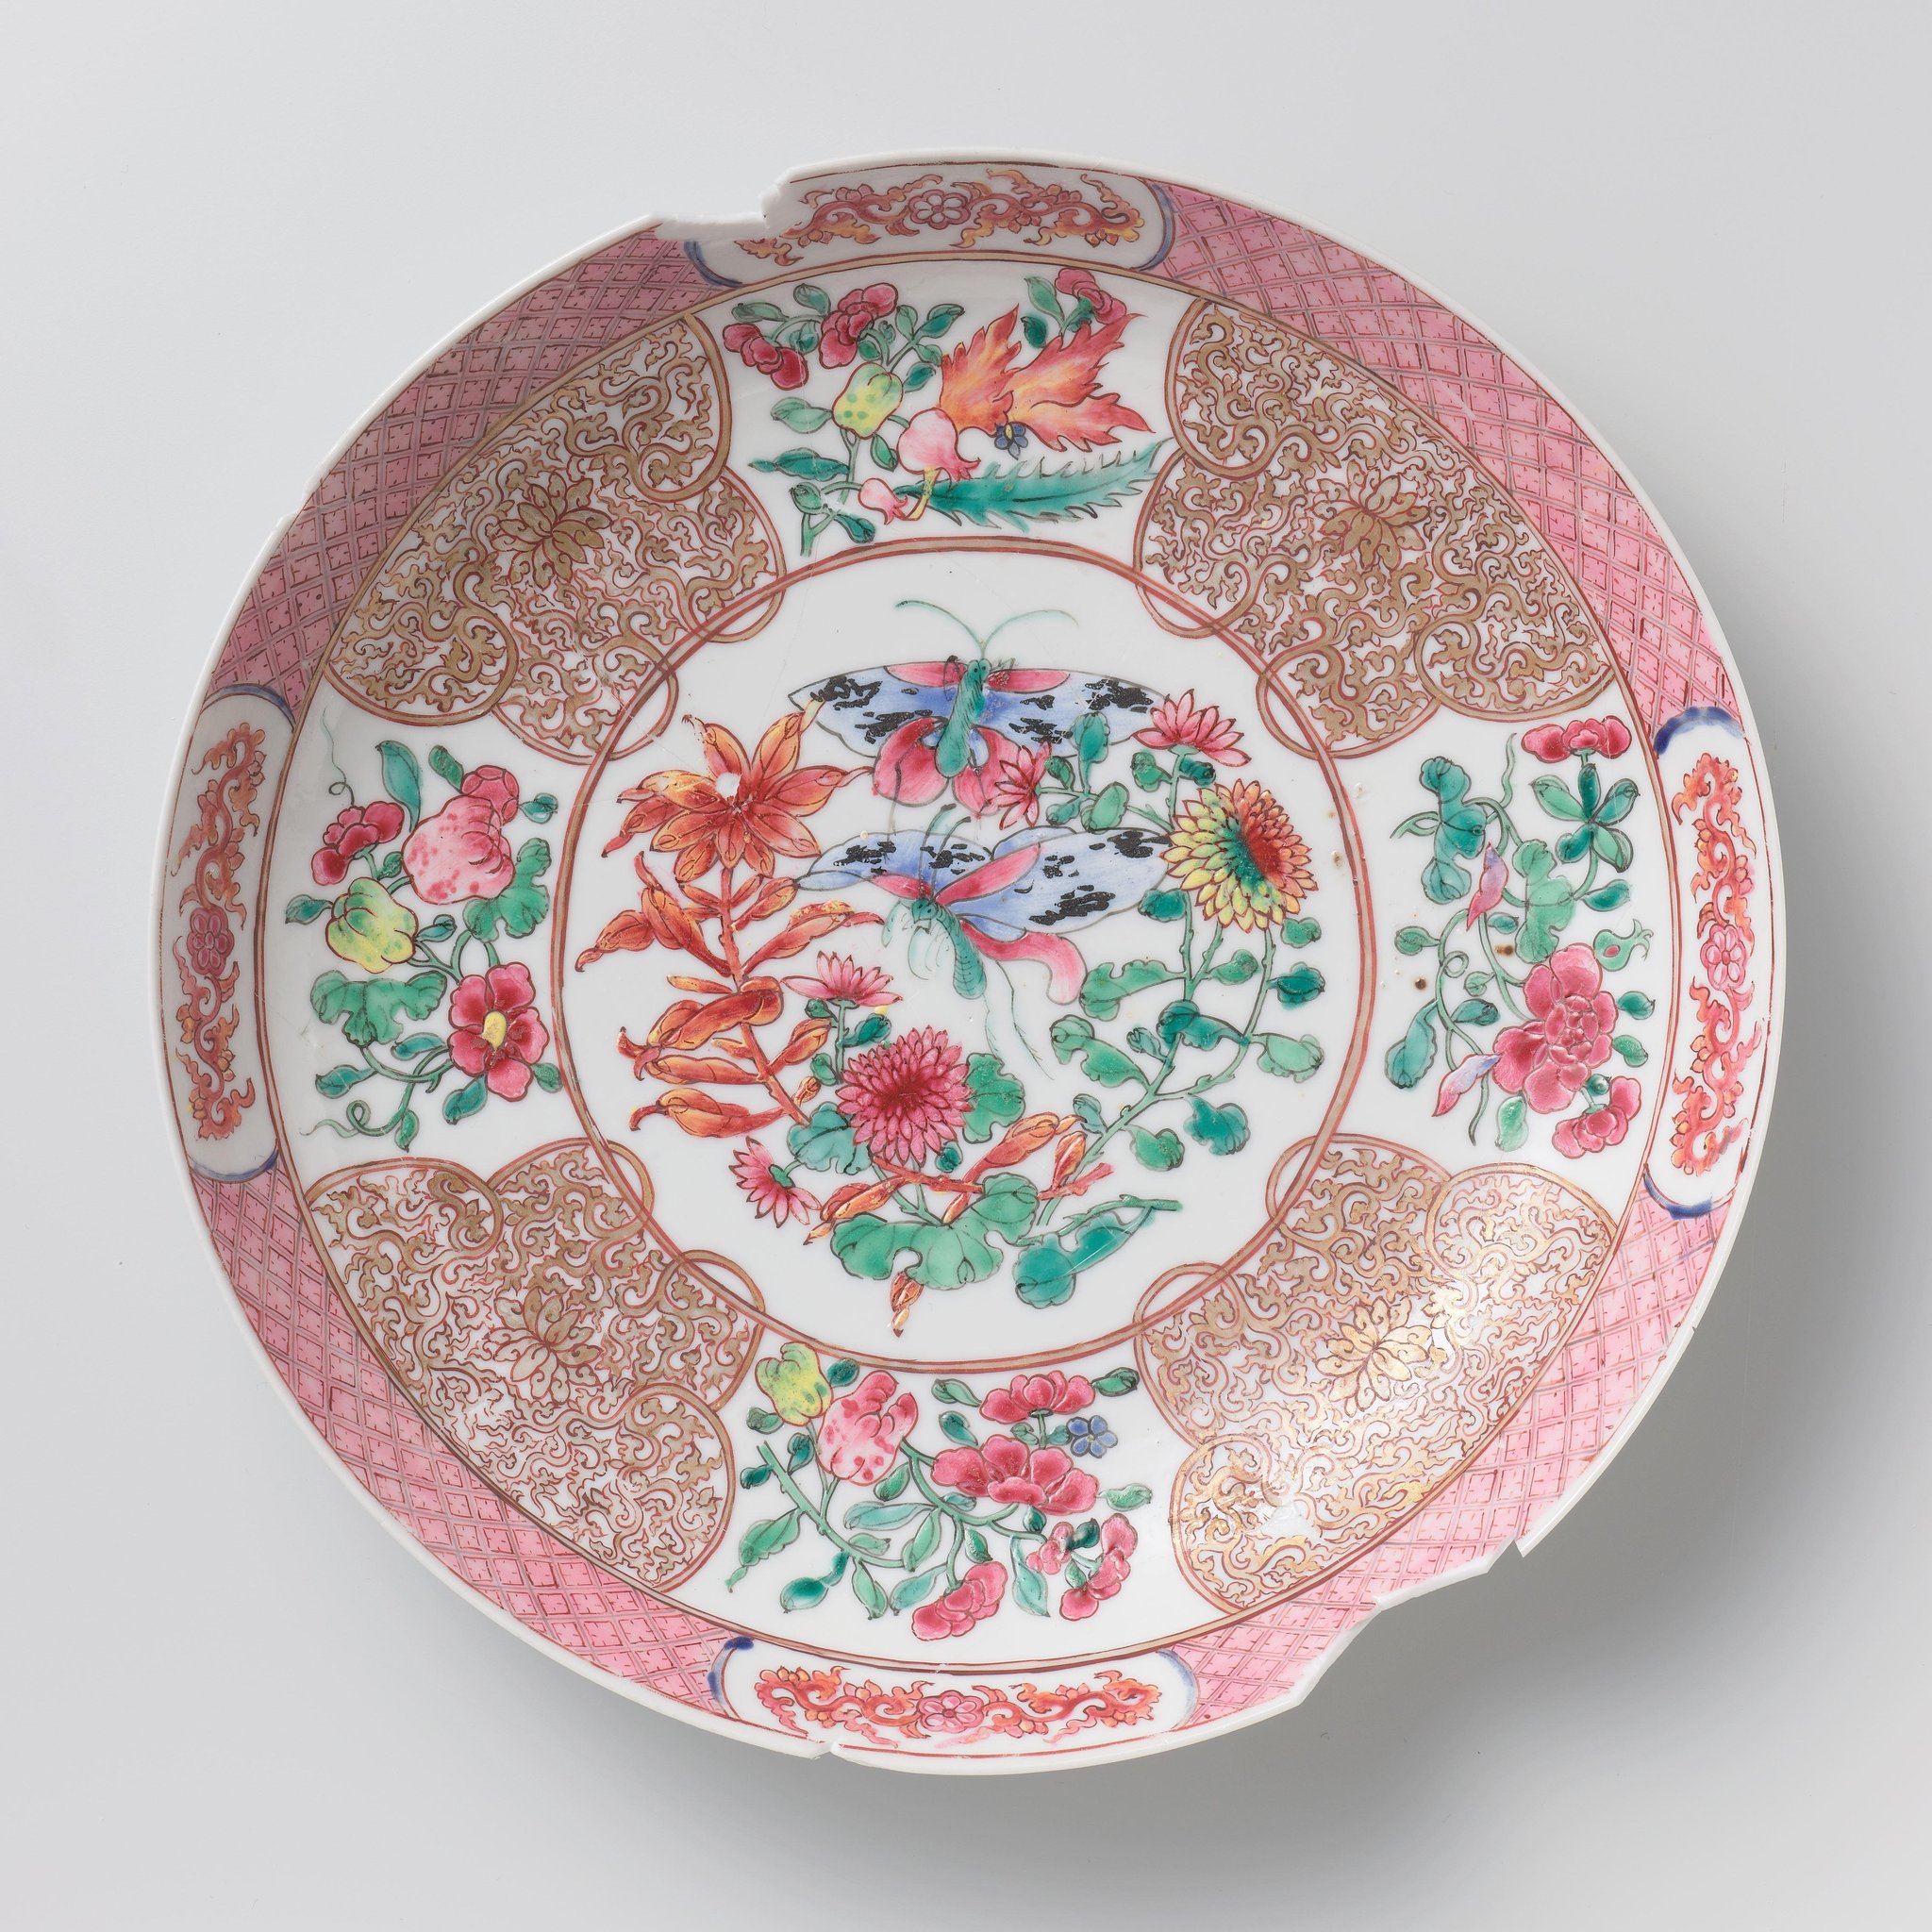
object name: dish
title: Saucer-dish with flower sprays, scrolls and diaper-pattern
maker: Anonymous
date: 1725-1749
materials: glaze, gold, paint, porcelain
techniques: firing, gilding, turning, vitrification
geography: china